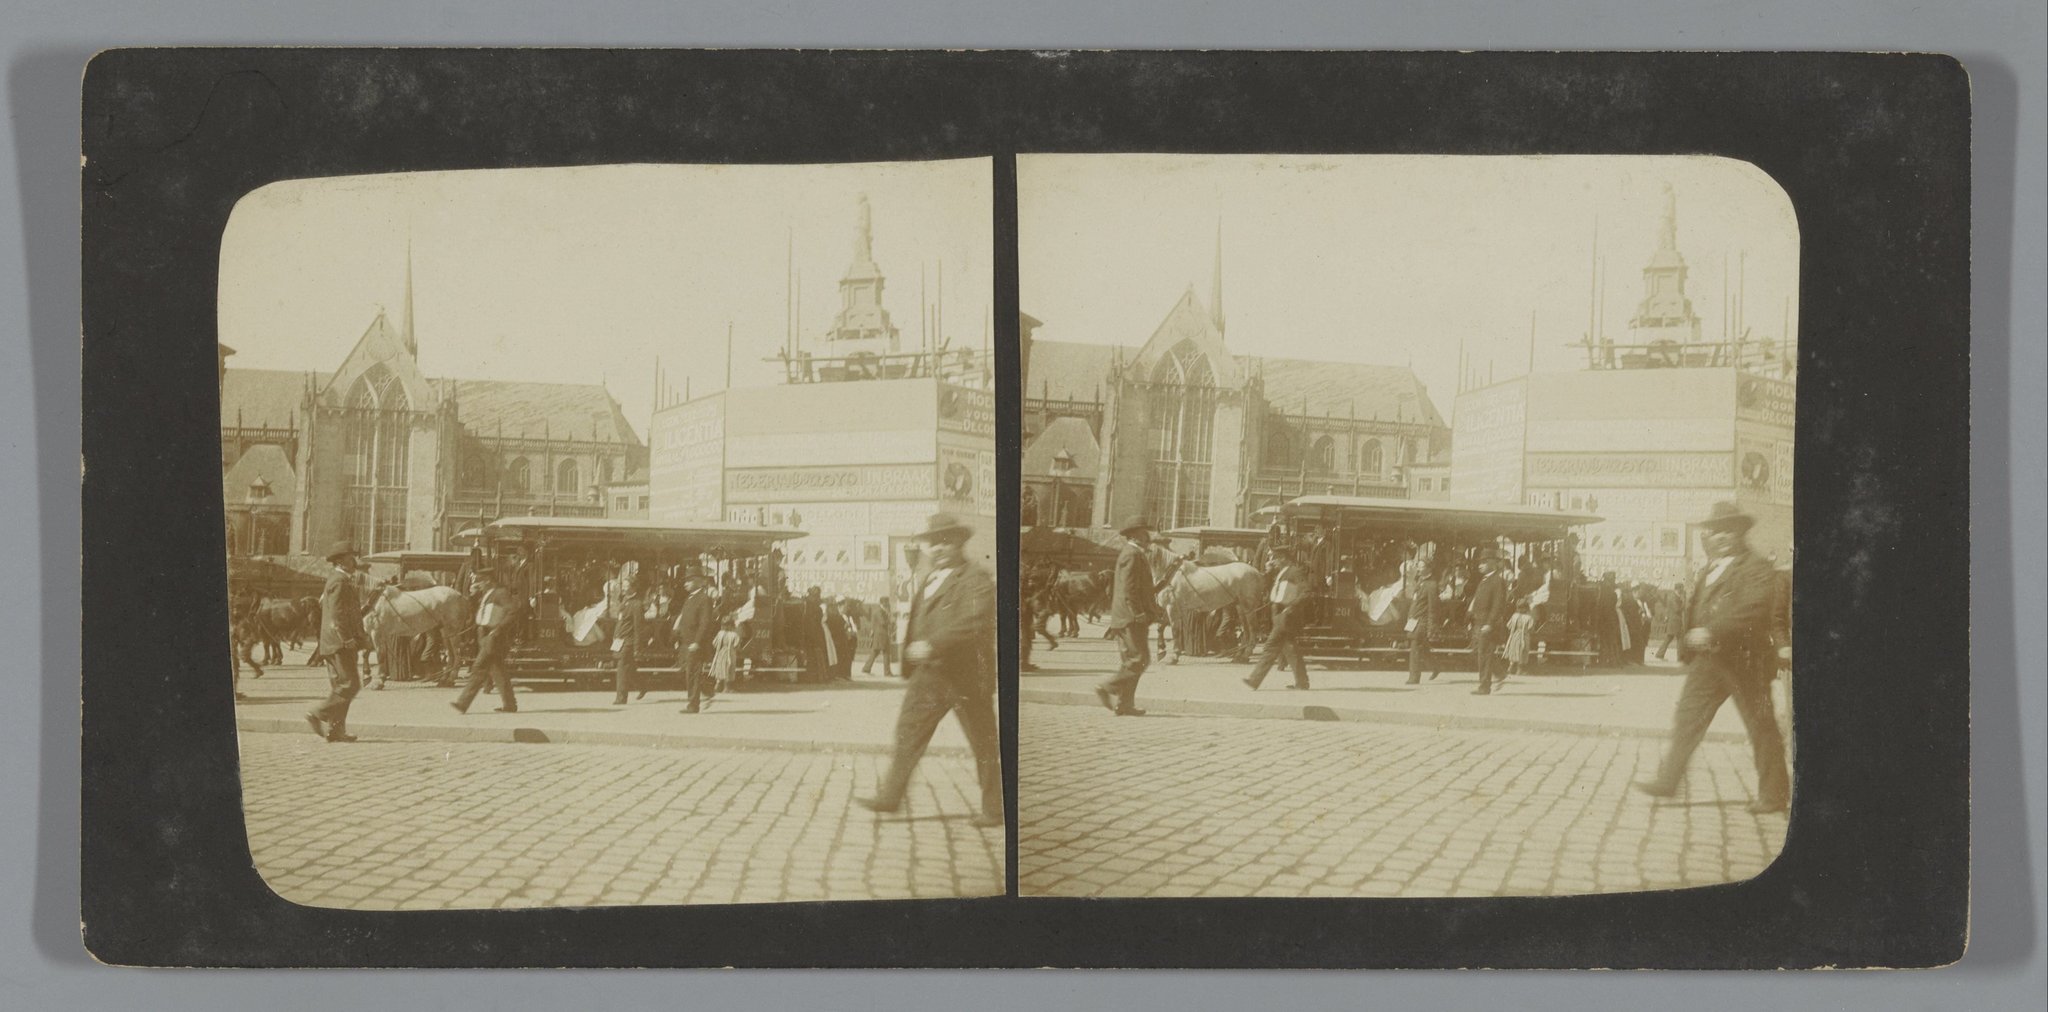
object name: stereograph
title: Voorbijgangers en paardentrams op de Dam met het beeld 'De Eendracht', beter bekend als 'Naatje van de Dam' (in de steigers), Amsterdam, Nederland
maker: adrianus scheltema-beduin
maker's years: 1864-1944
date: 1898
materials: paper, cardboard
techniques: collodion silver print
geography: amsterdam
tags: square, place, circus, etc.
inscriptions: inscription: ‘Amsterdam/ Dam 1898.’